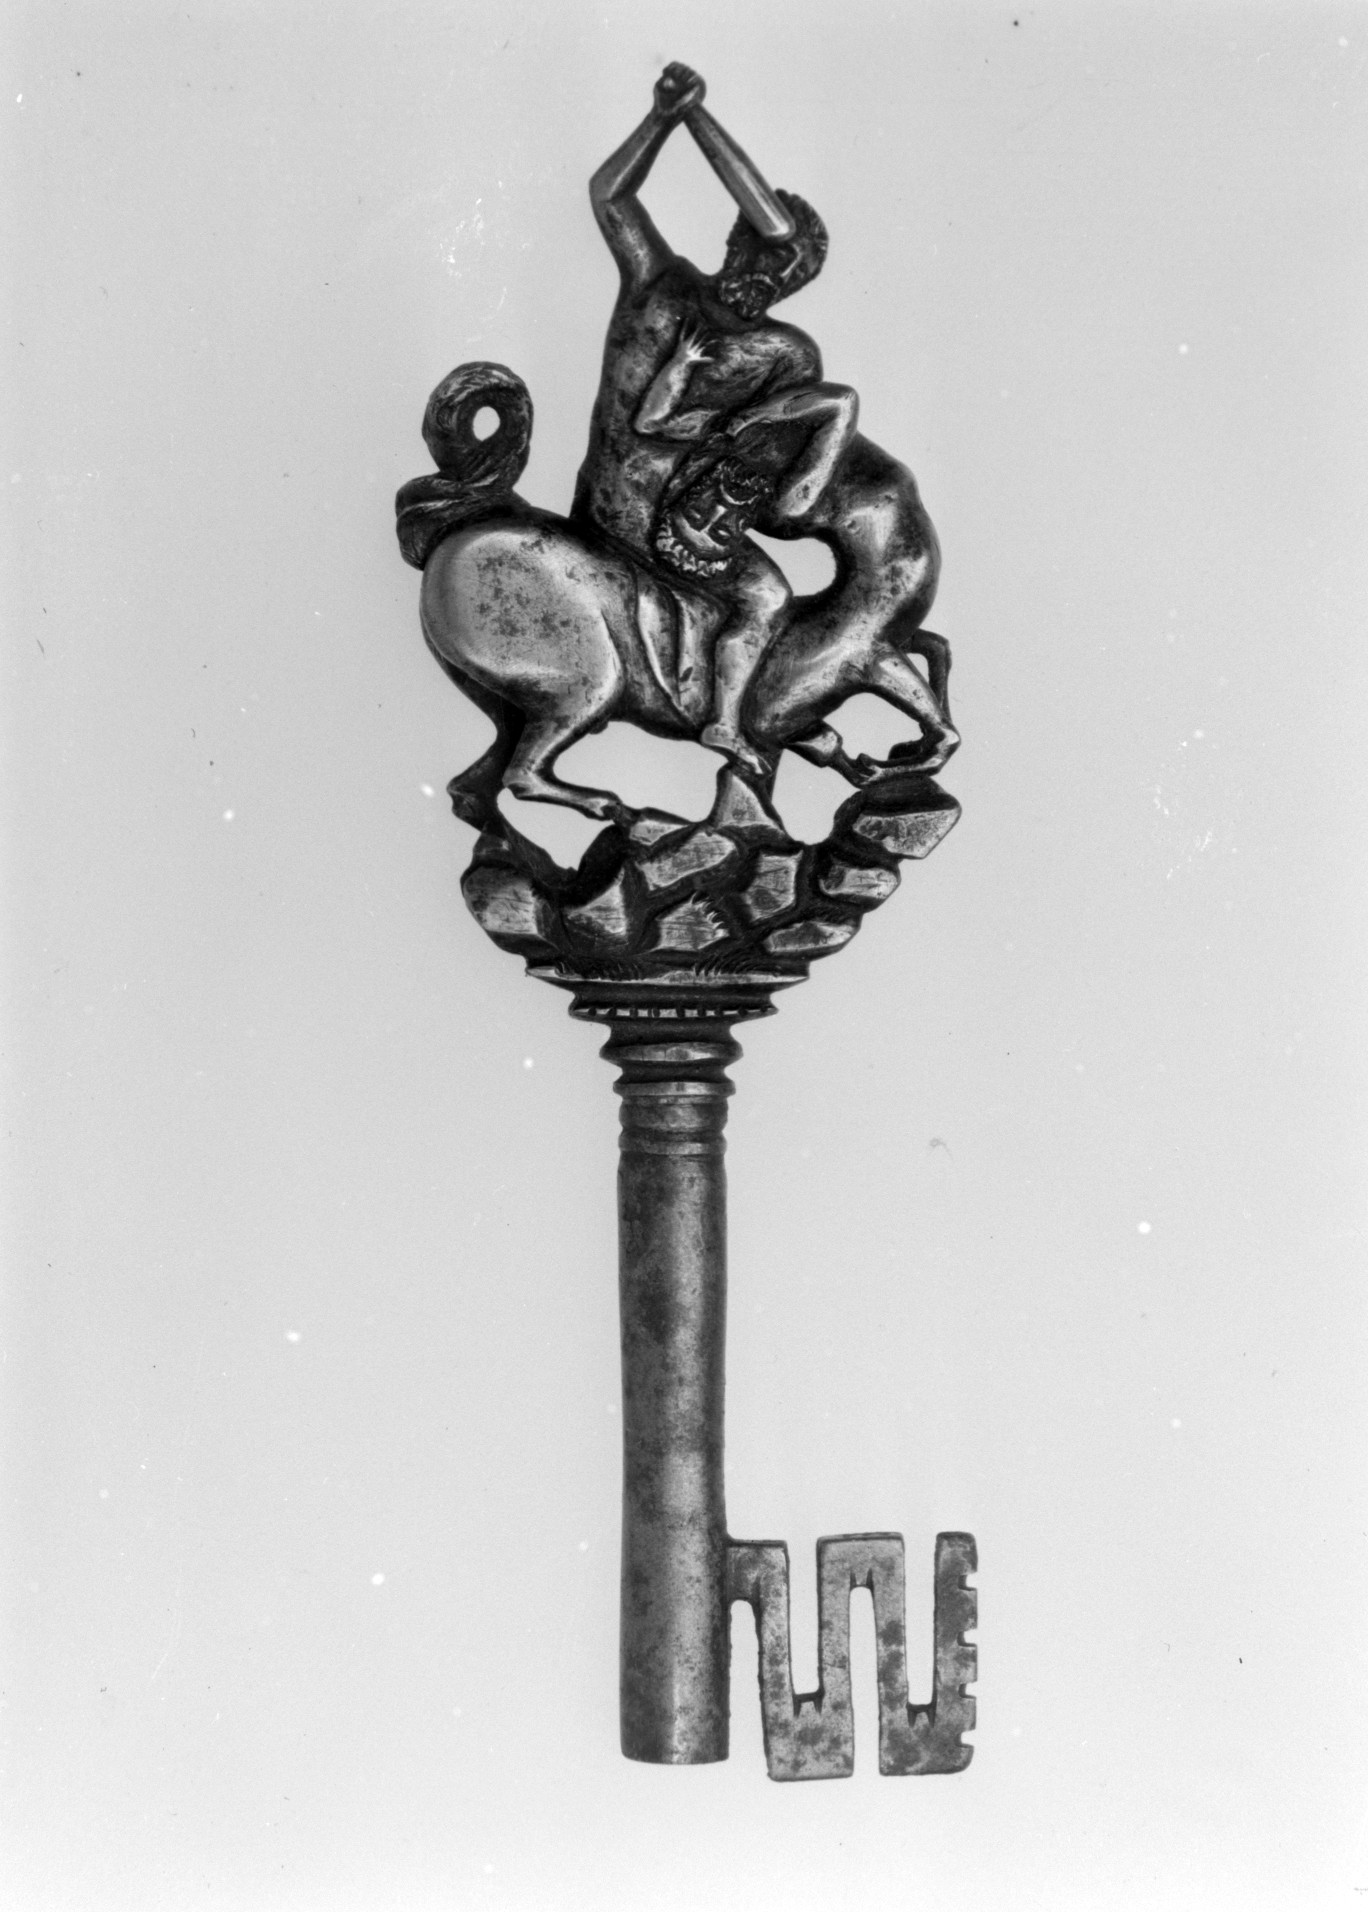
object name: key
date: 1501-1600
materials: iron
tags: centaurs